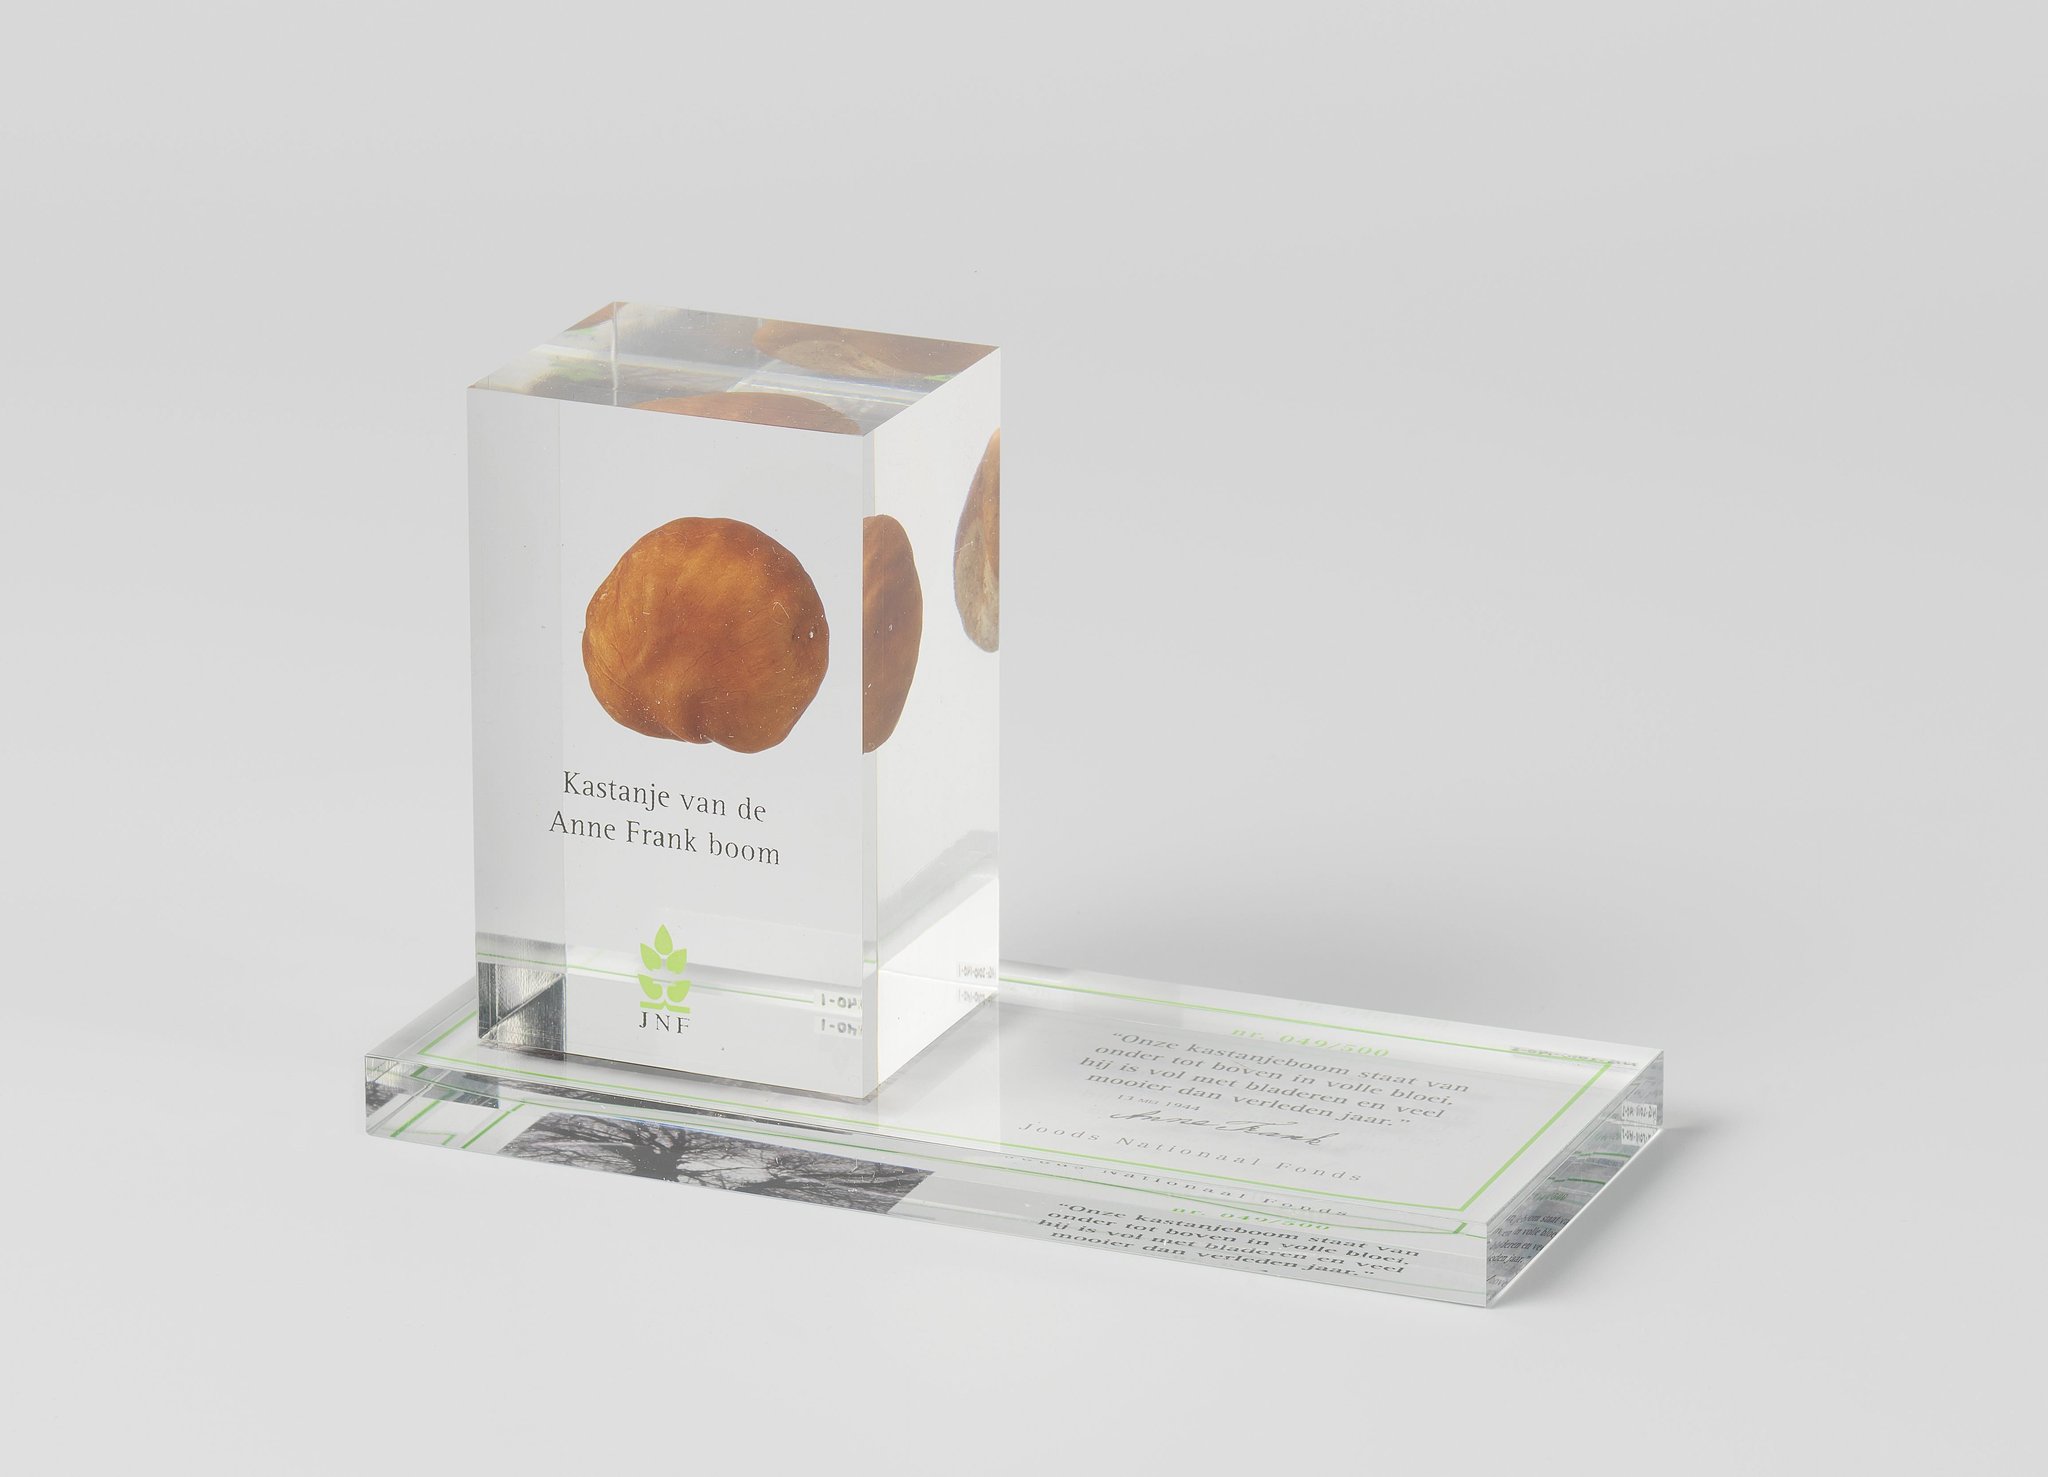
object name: commemorative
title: Plexiglazen zuiltje met kastanje Anne Frankboom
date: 2010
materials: wood, plastic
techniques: casting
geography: netherlands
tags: anne frank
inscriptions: : ‘Kastanje van de Anne Frank boom.’, : ‘JNF’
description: Plexiglazen zuiltje waarin een kastanje van de Anne Frankboom gevat zit. Met opdruk "kastanje van de Anne Frank boom" en het logo van het Joods Nationaal Fonds.